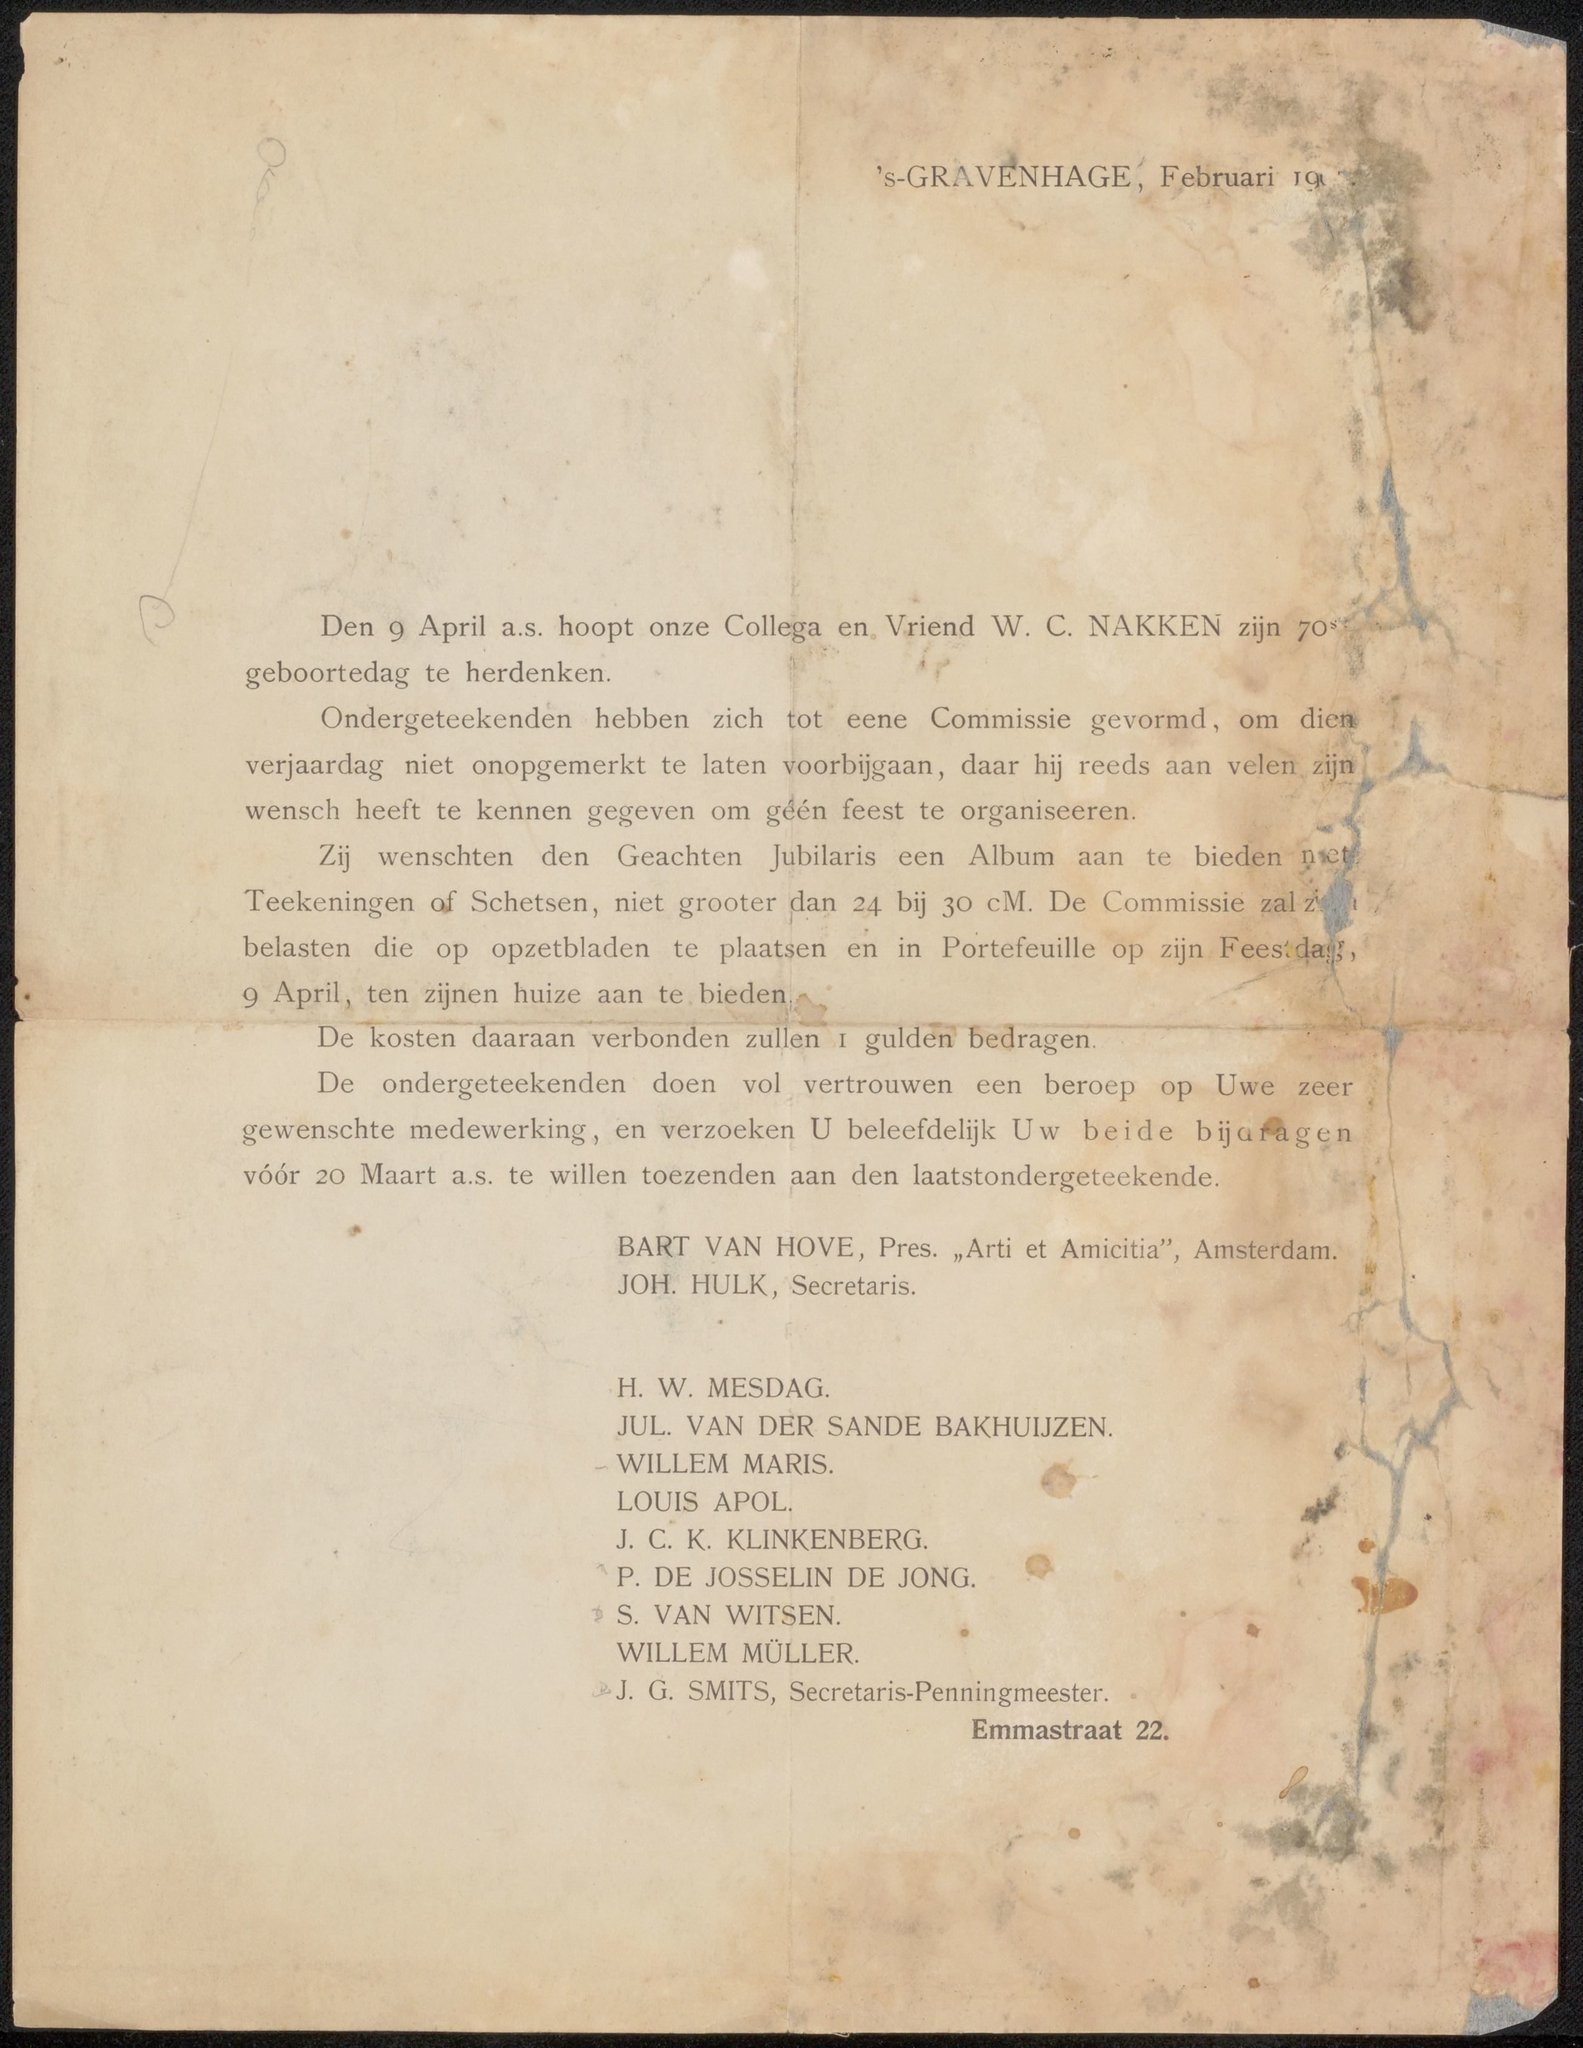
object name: letter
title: Brief aan Philip Zilcken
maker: johannes frederick hulk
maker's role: painter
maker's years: 1875-1913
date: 1902-1905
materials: ink, paper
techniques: pen, printing, writing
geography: the hague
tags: willem carel nakken, the hague, painter, draughtsman, philip zilcken, drawing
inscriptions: collector's mark: ‘RPK’